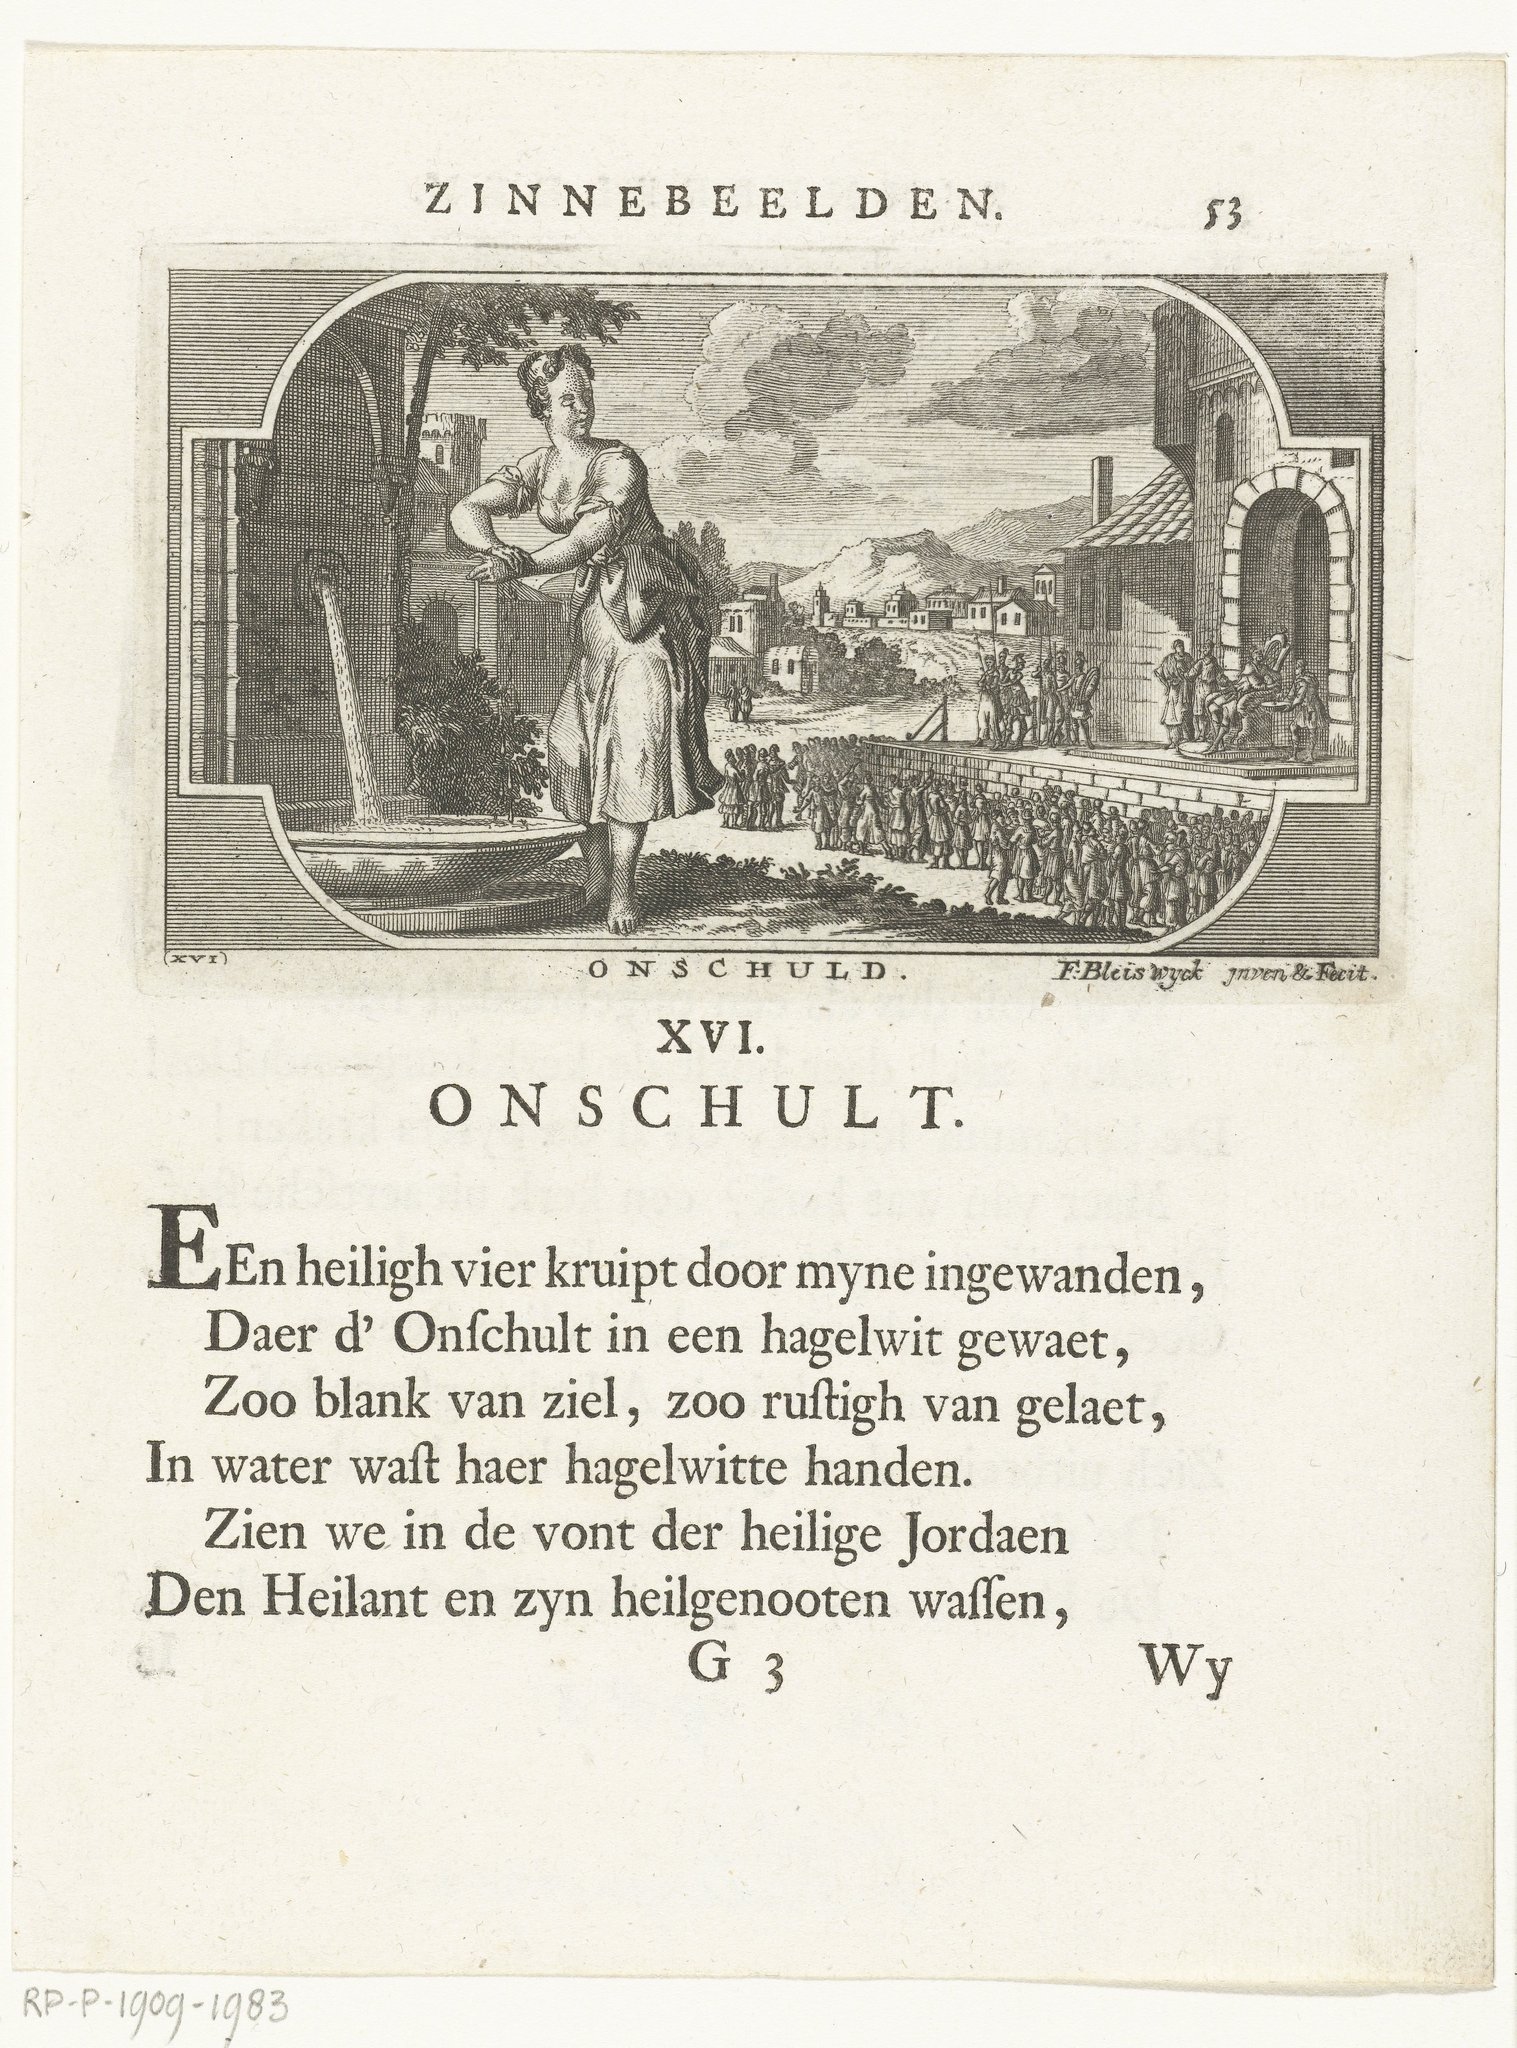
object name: book illustration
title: Embleem met allegorie op onschuld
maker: françois van bleyswijck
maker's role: draughtsman, print maker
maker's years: 1671-1746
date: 1681-1737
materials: paper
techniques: etching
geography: leiden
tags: pilate washing his hands (in innocence), innocence; 'innocenza', 'innocenza o purità' (ripa), washing one's hands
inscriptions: collector's mark: Lugt 2228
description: Embleem met allegorie op onschuld verbeeld als vrouw die haar handen wast bij een fontein. In het landschap is de bijbelse scène weergegeven waarin Pilatus zijn handen in onschuld wast. Onder de voorstelling en op het verso staat een gedicht.